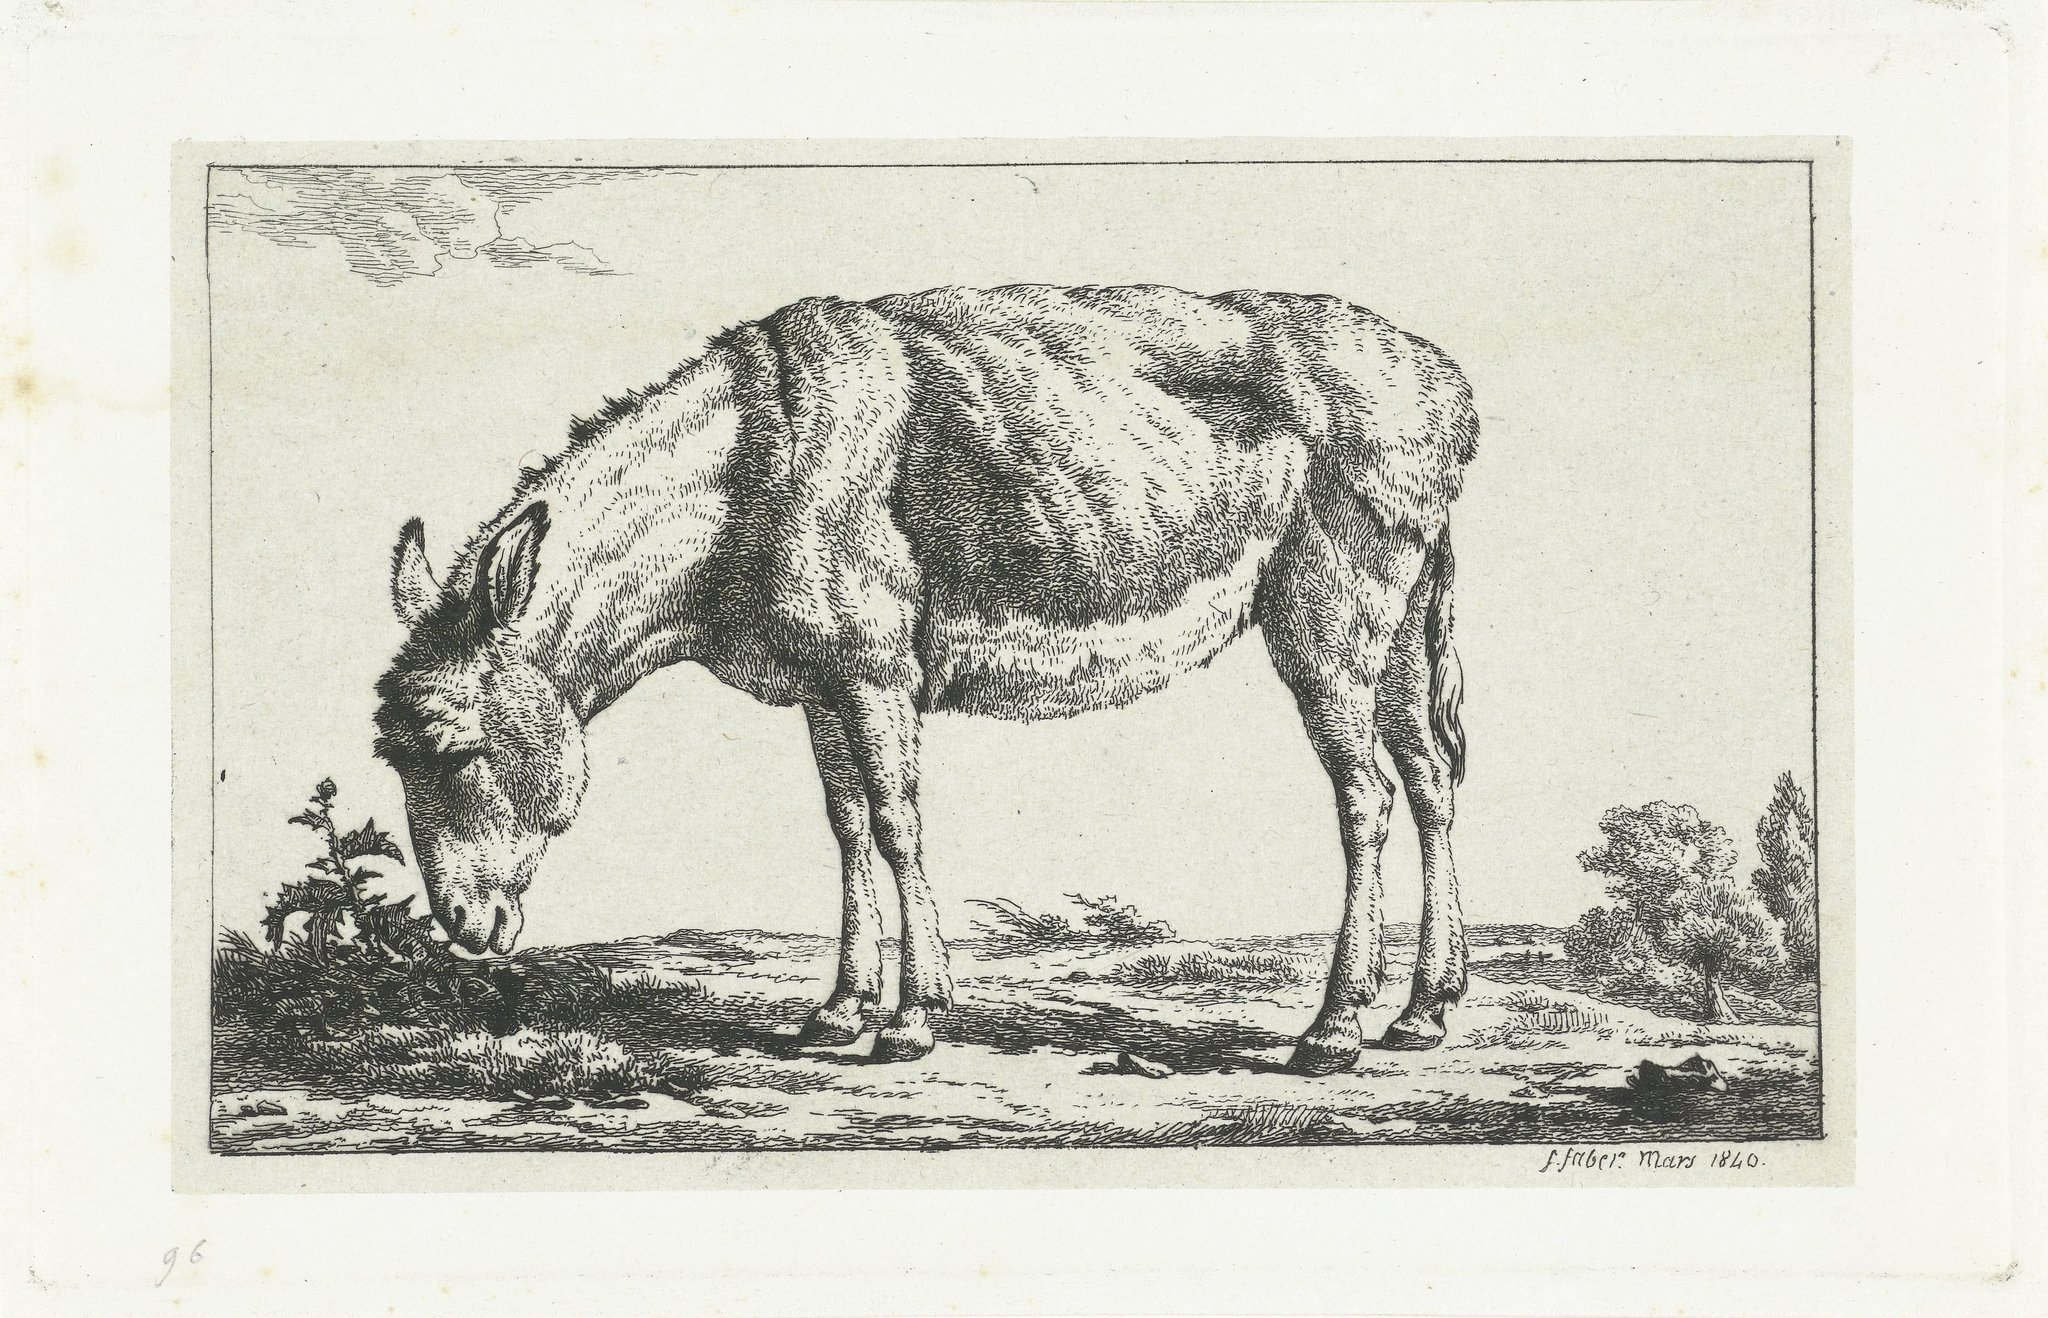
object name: print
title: Grazende ezel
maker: frédéric théodore faber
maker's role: print maker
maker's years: 1782-1844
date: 1840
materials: paper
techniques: etching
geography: brussels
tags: ass, donkey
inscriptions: collector's mark: Lugt 1485, collector's mark: Lugt 2228